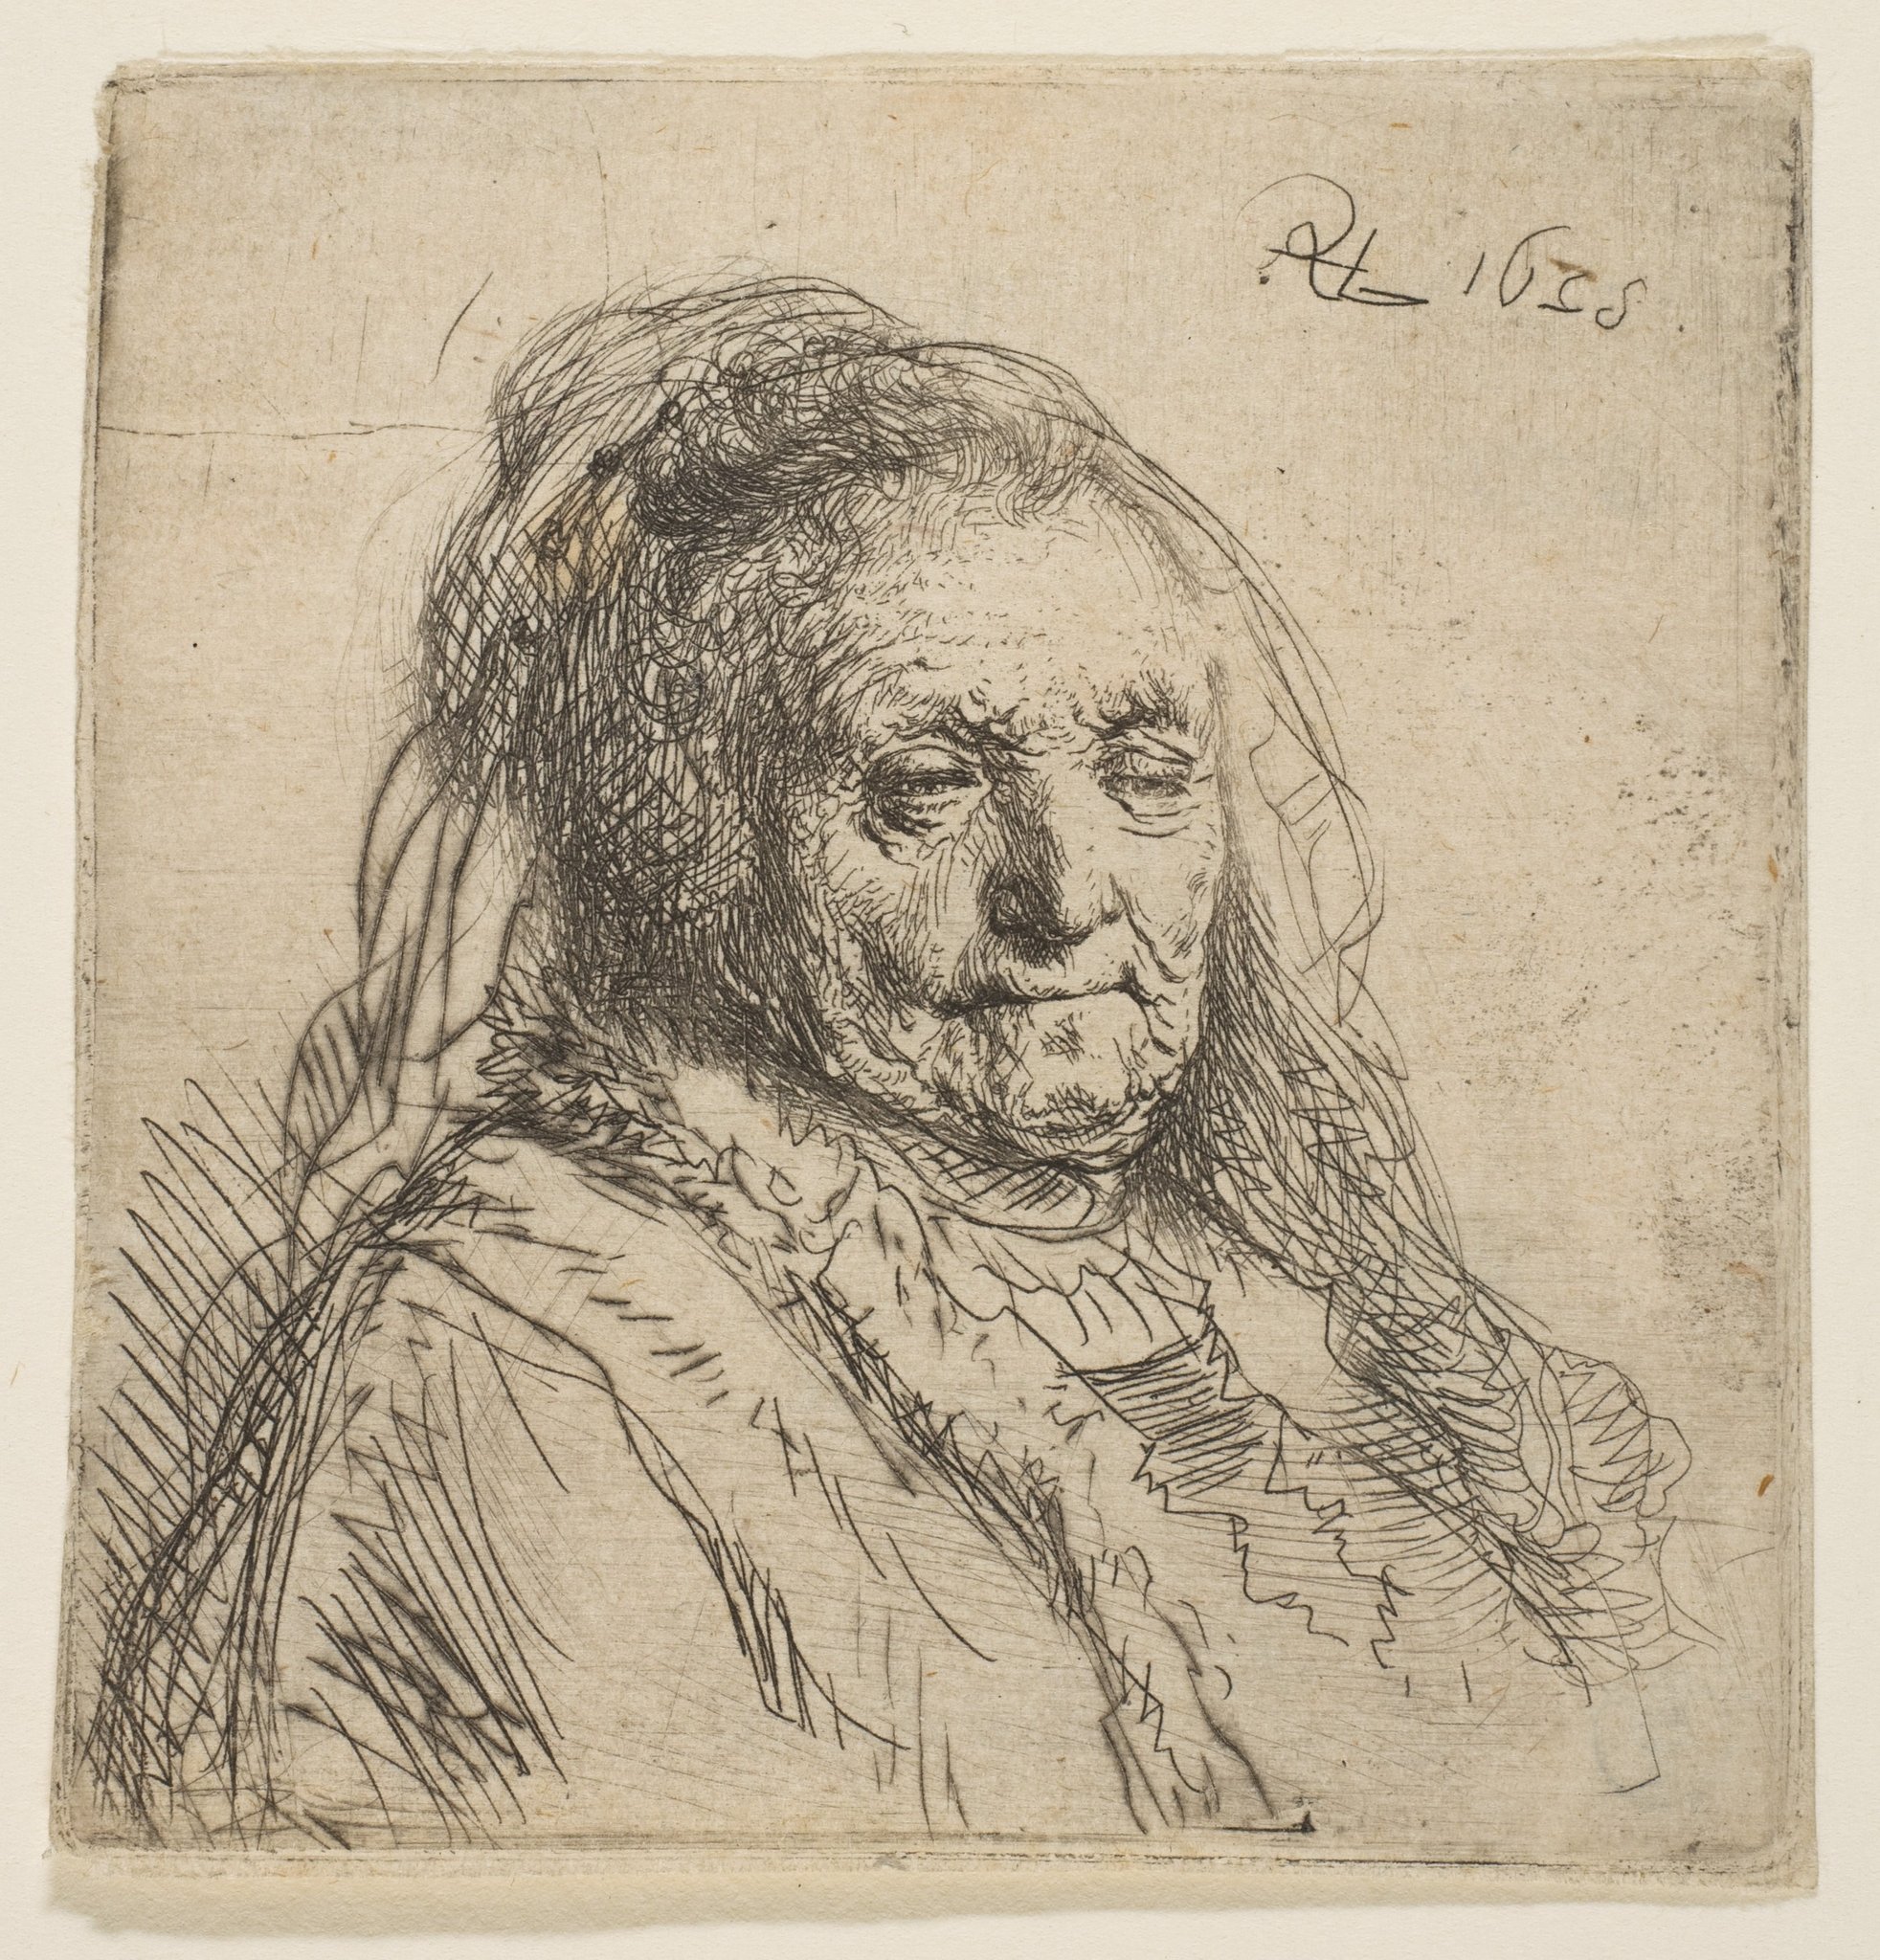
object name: printtest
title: The Artist's Mother: Head and Bust, Three-Quarters Right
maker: rembrandt van rijn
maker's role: artist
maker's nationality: dutch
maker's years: 1606-1669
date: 1628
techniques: etching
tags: portraits,women